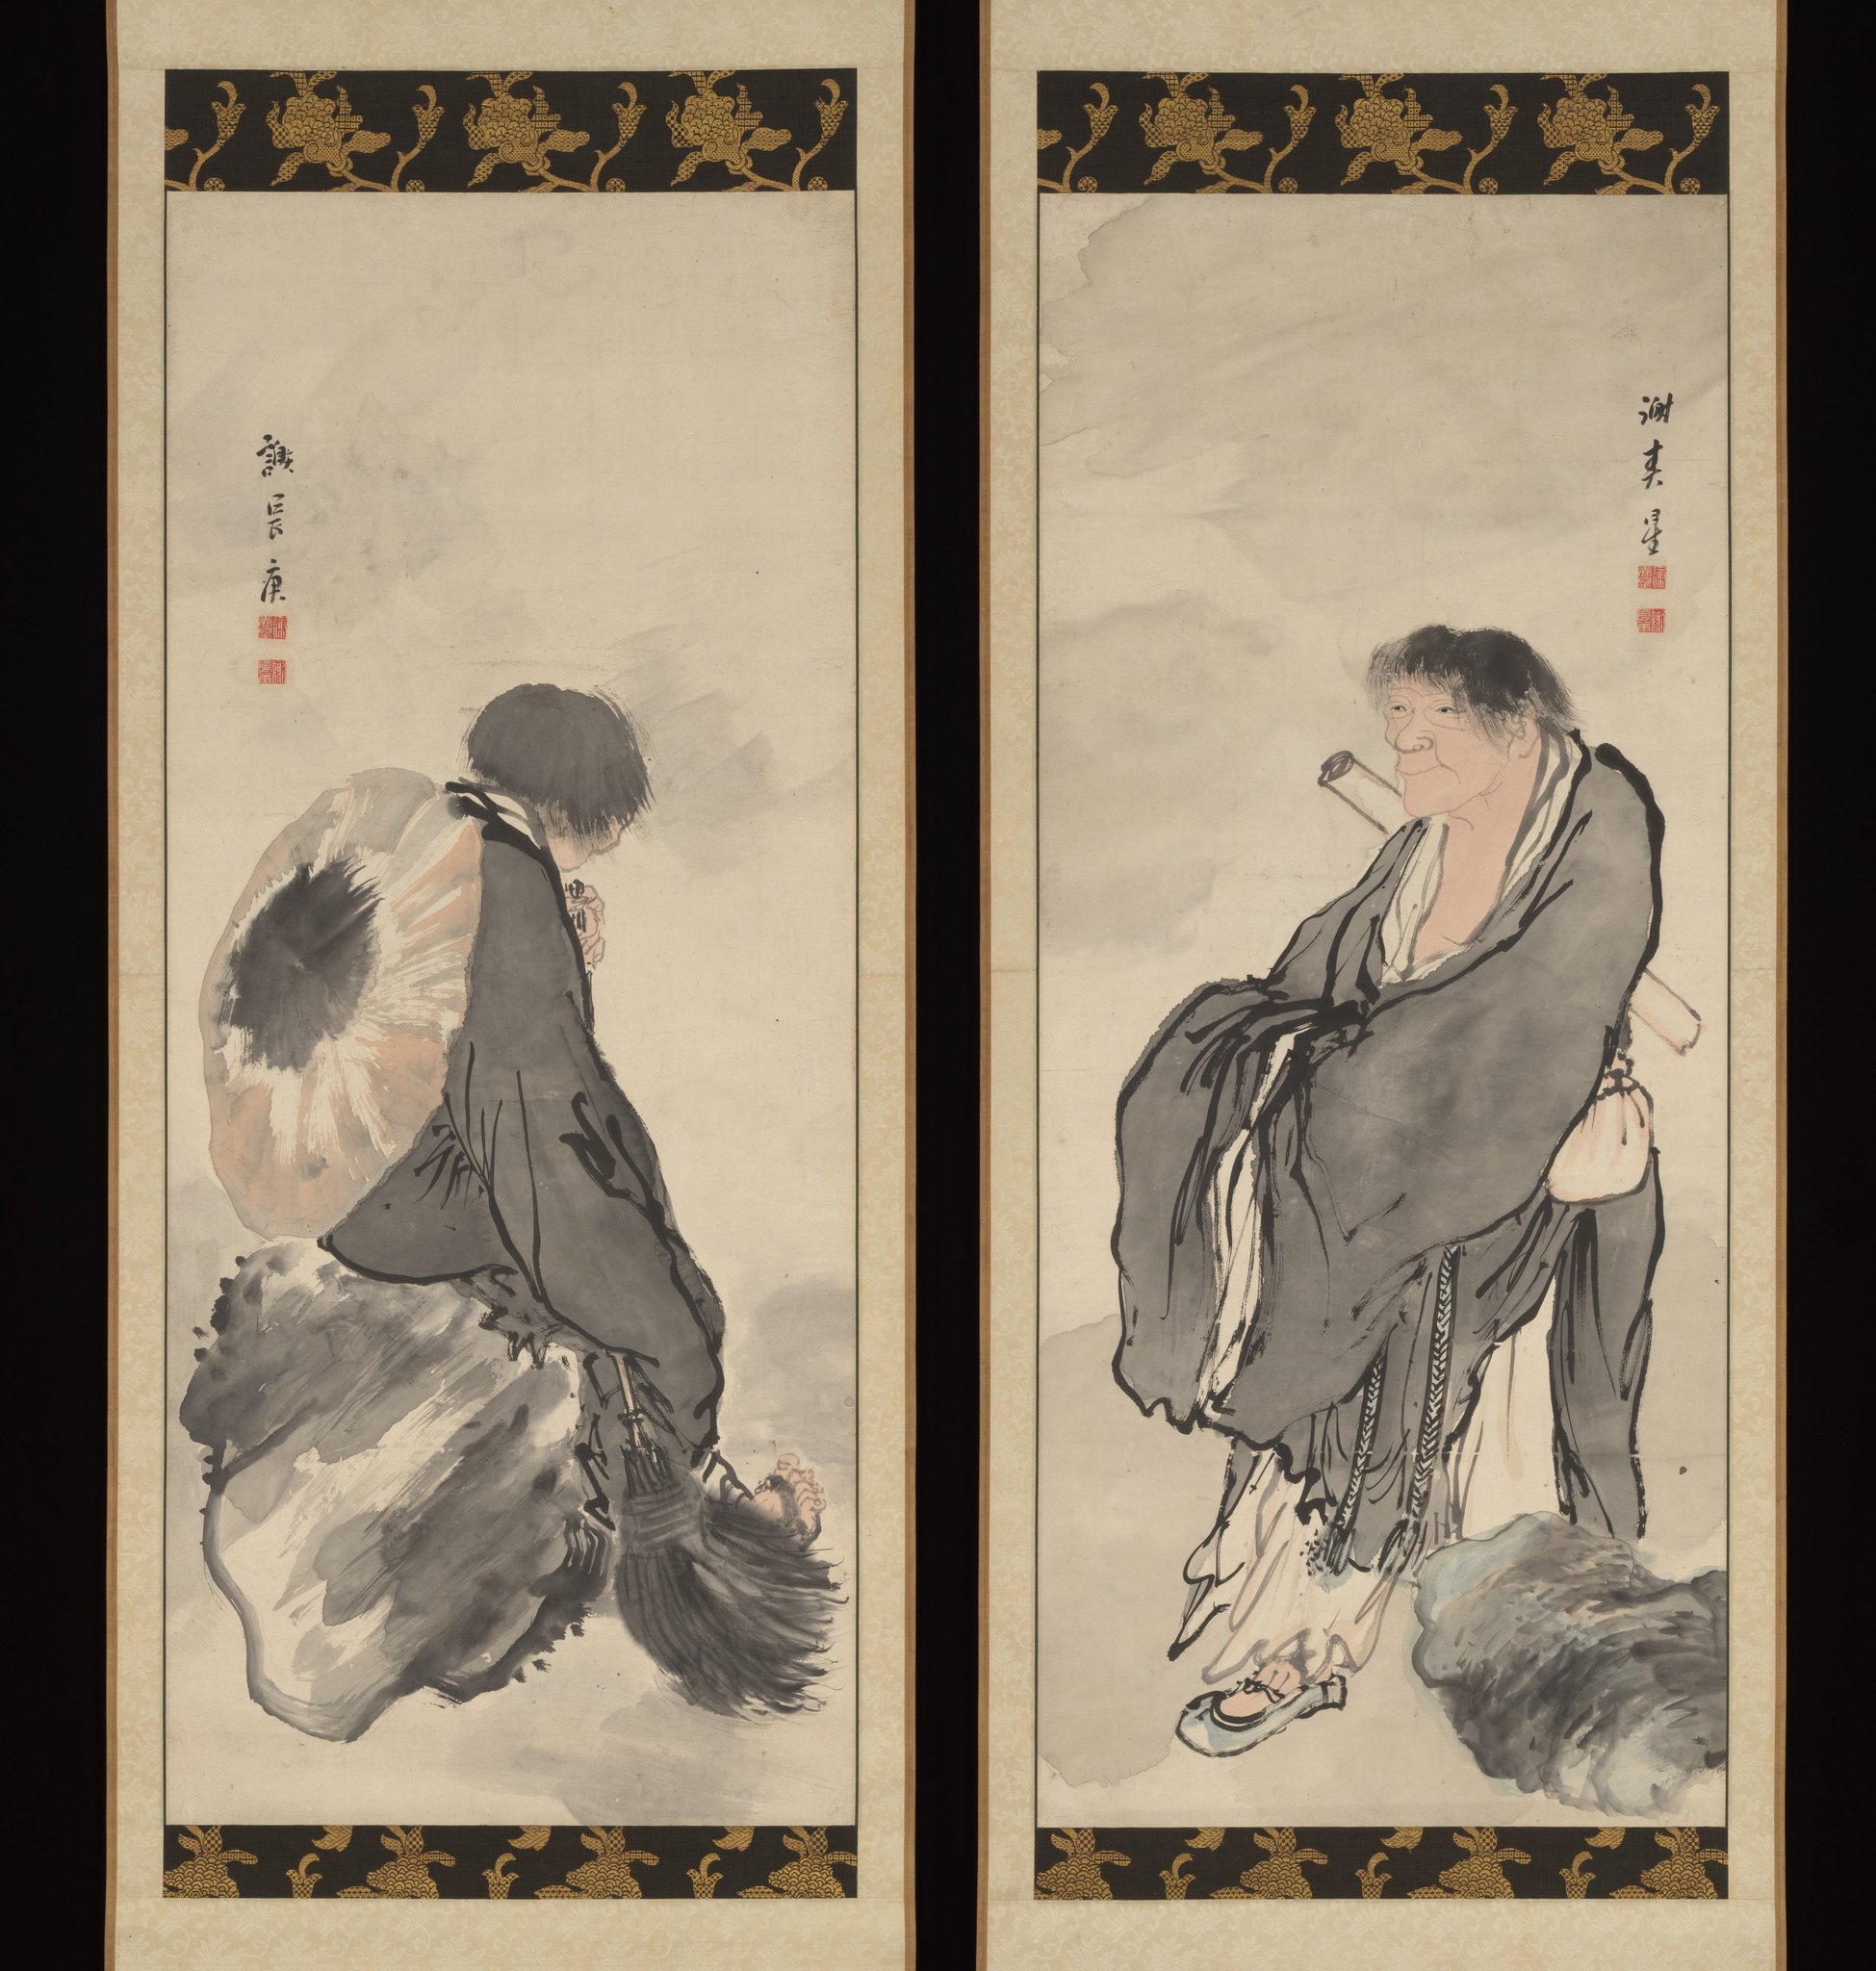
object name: hanging scroll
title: Hanshan and Shide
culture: japanese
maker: yosa buson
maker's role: artist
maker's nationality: japanese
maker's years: 1716-1783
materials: ink, paper